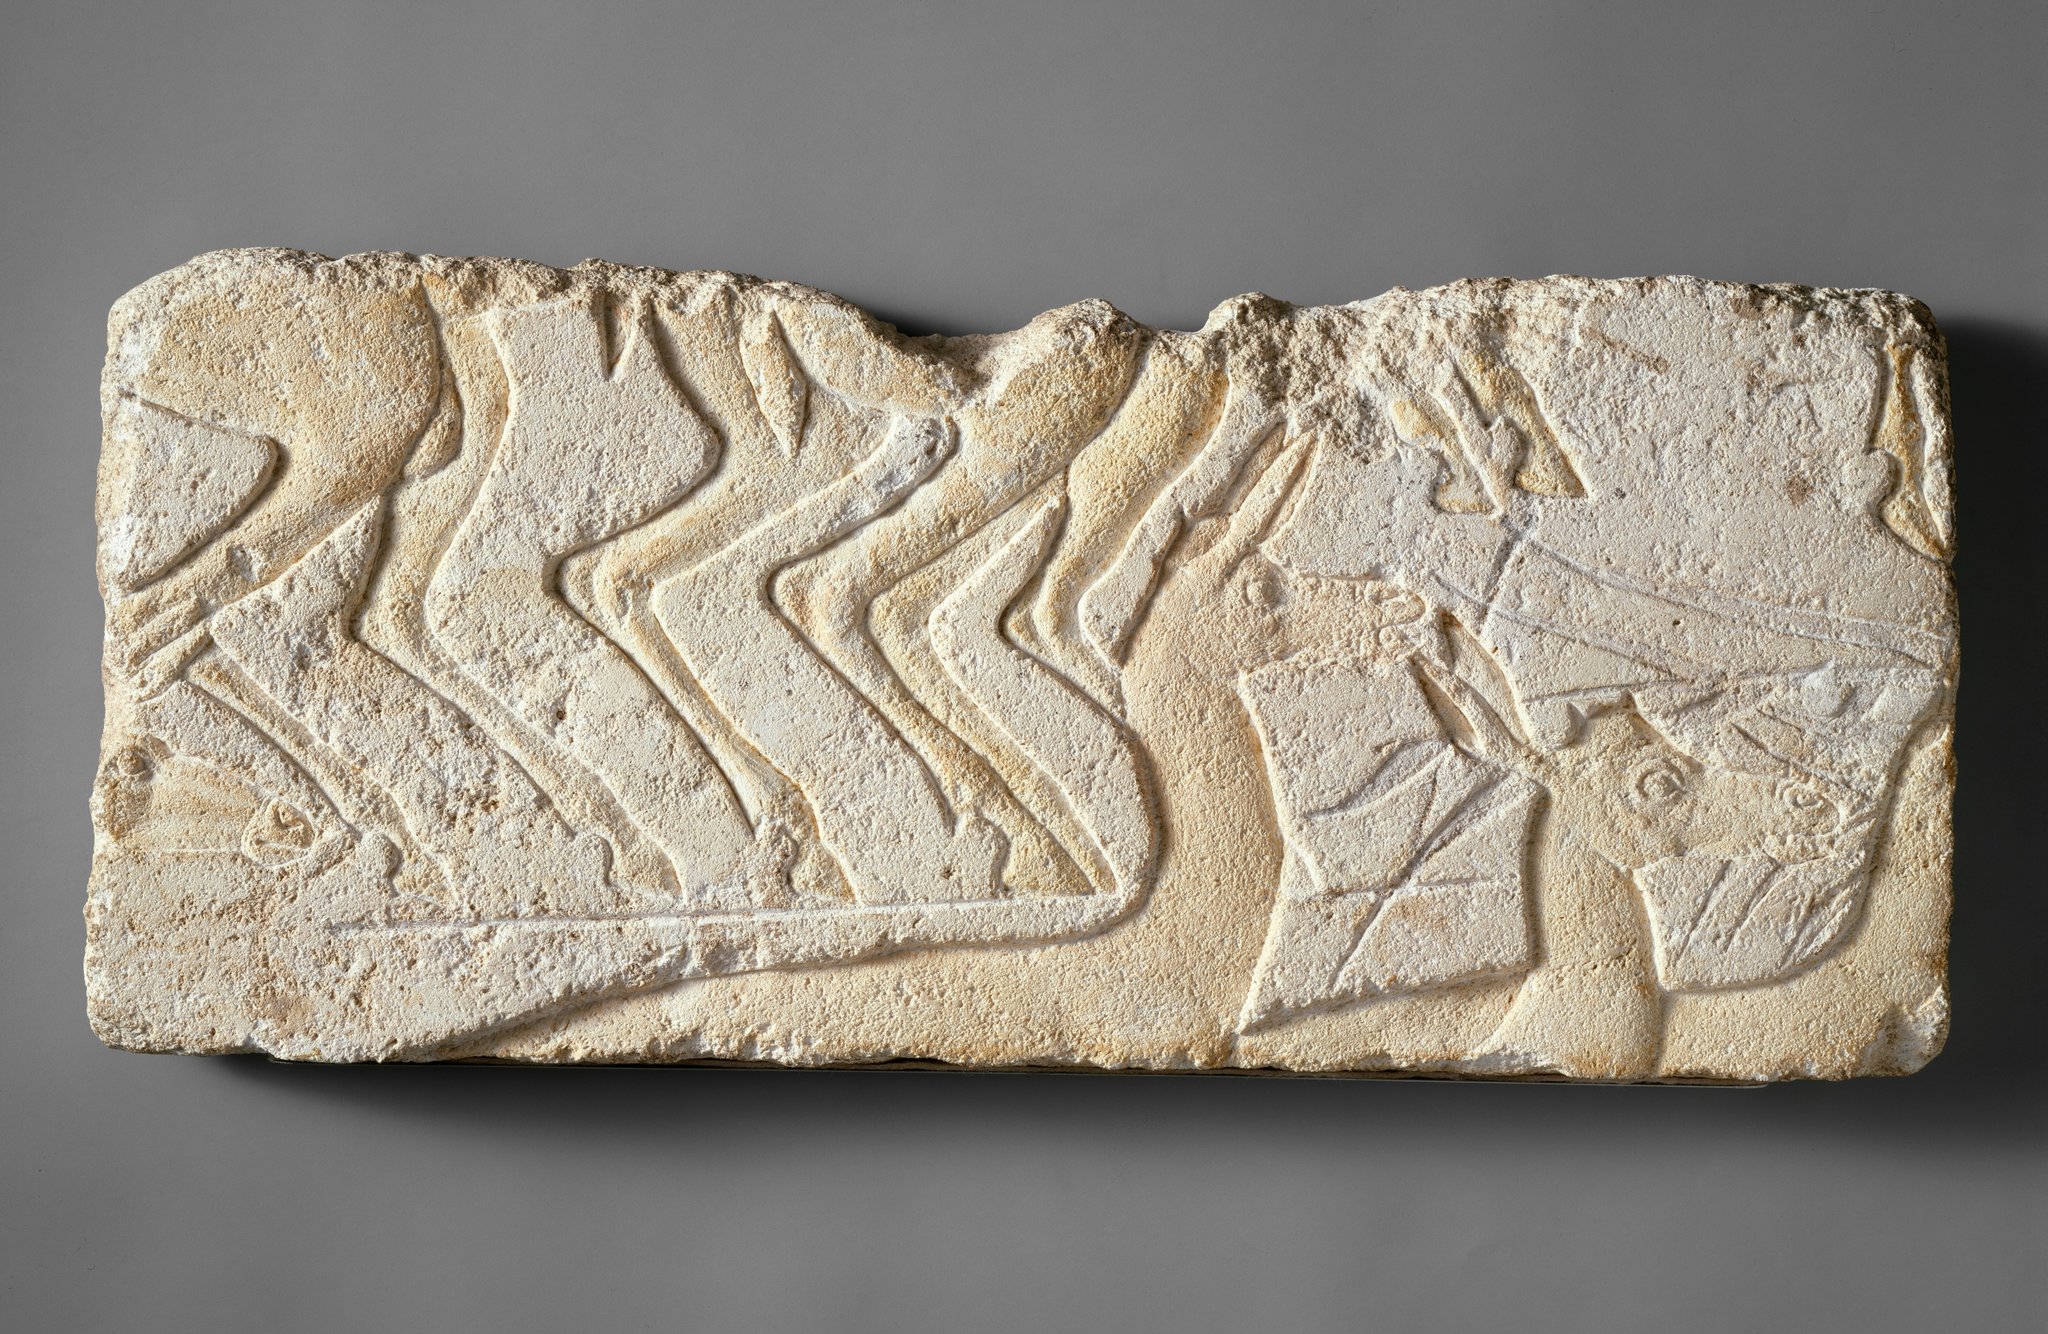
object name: talatat, desert scene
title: Desert Scene with Antelope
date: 1353-1336 BCE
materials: limestone, paint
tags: animals